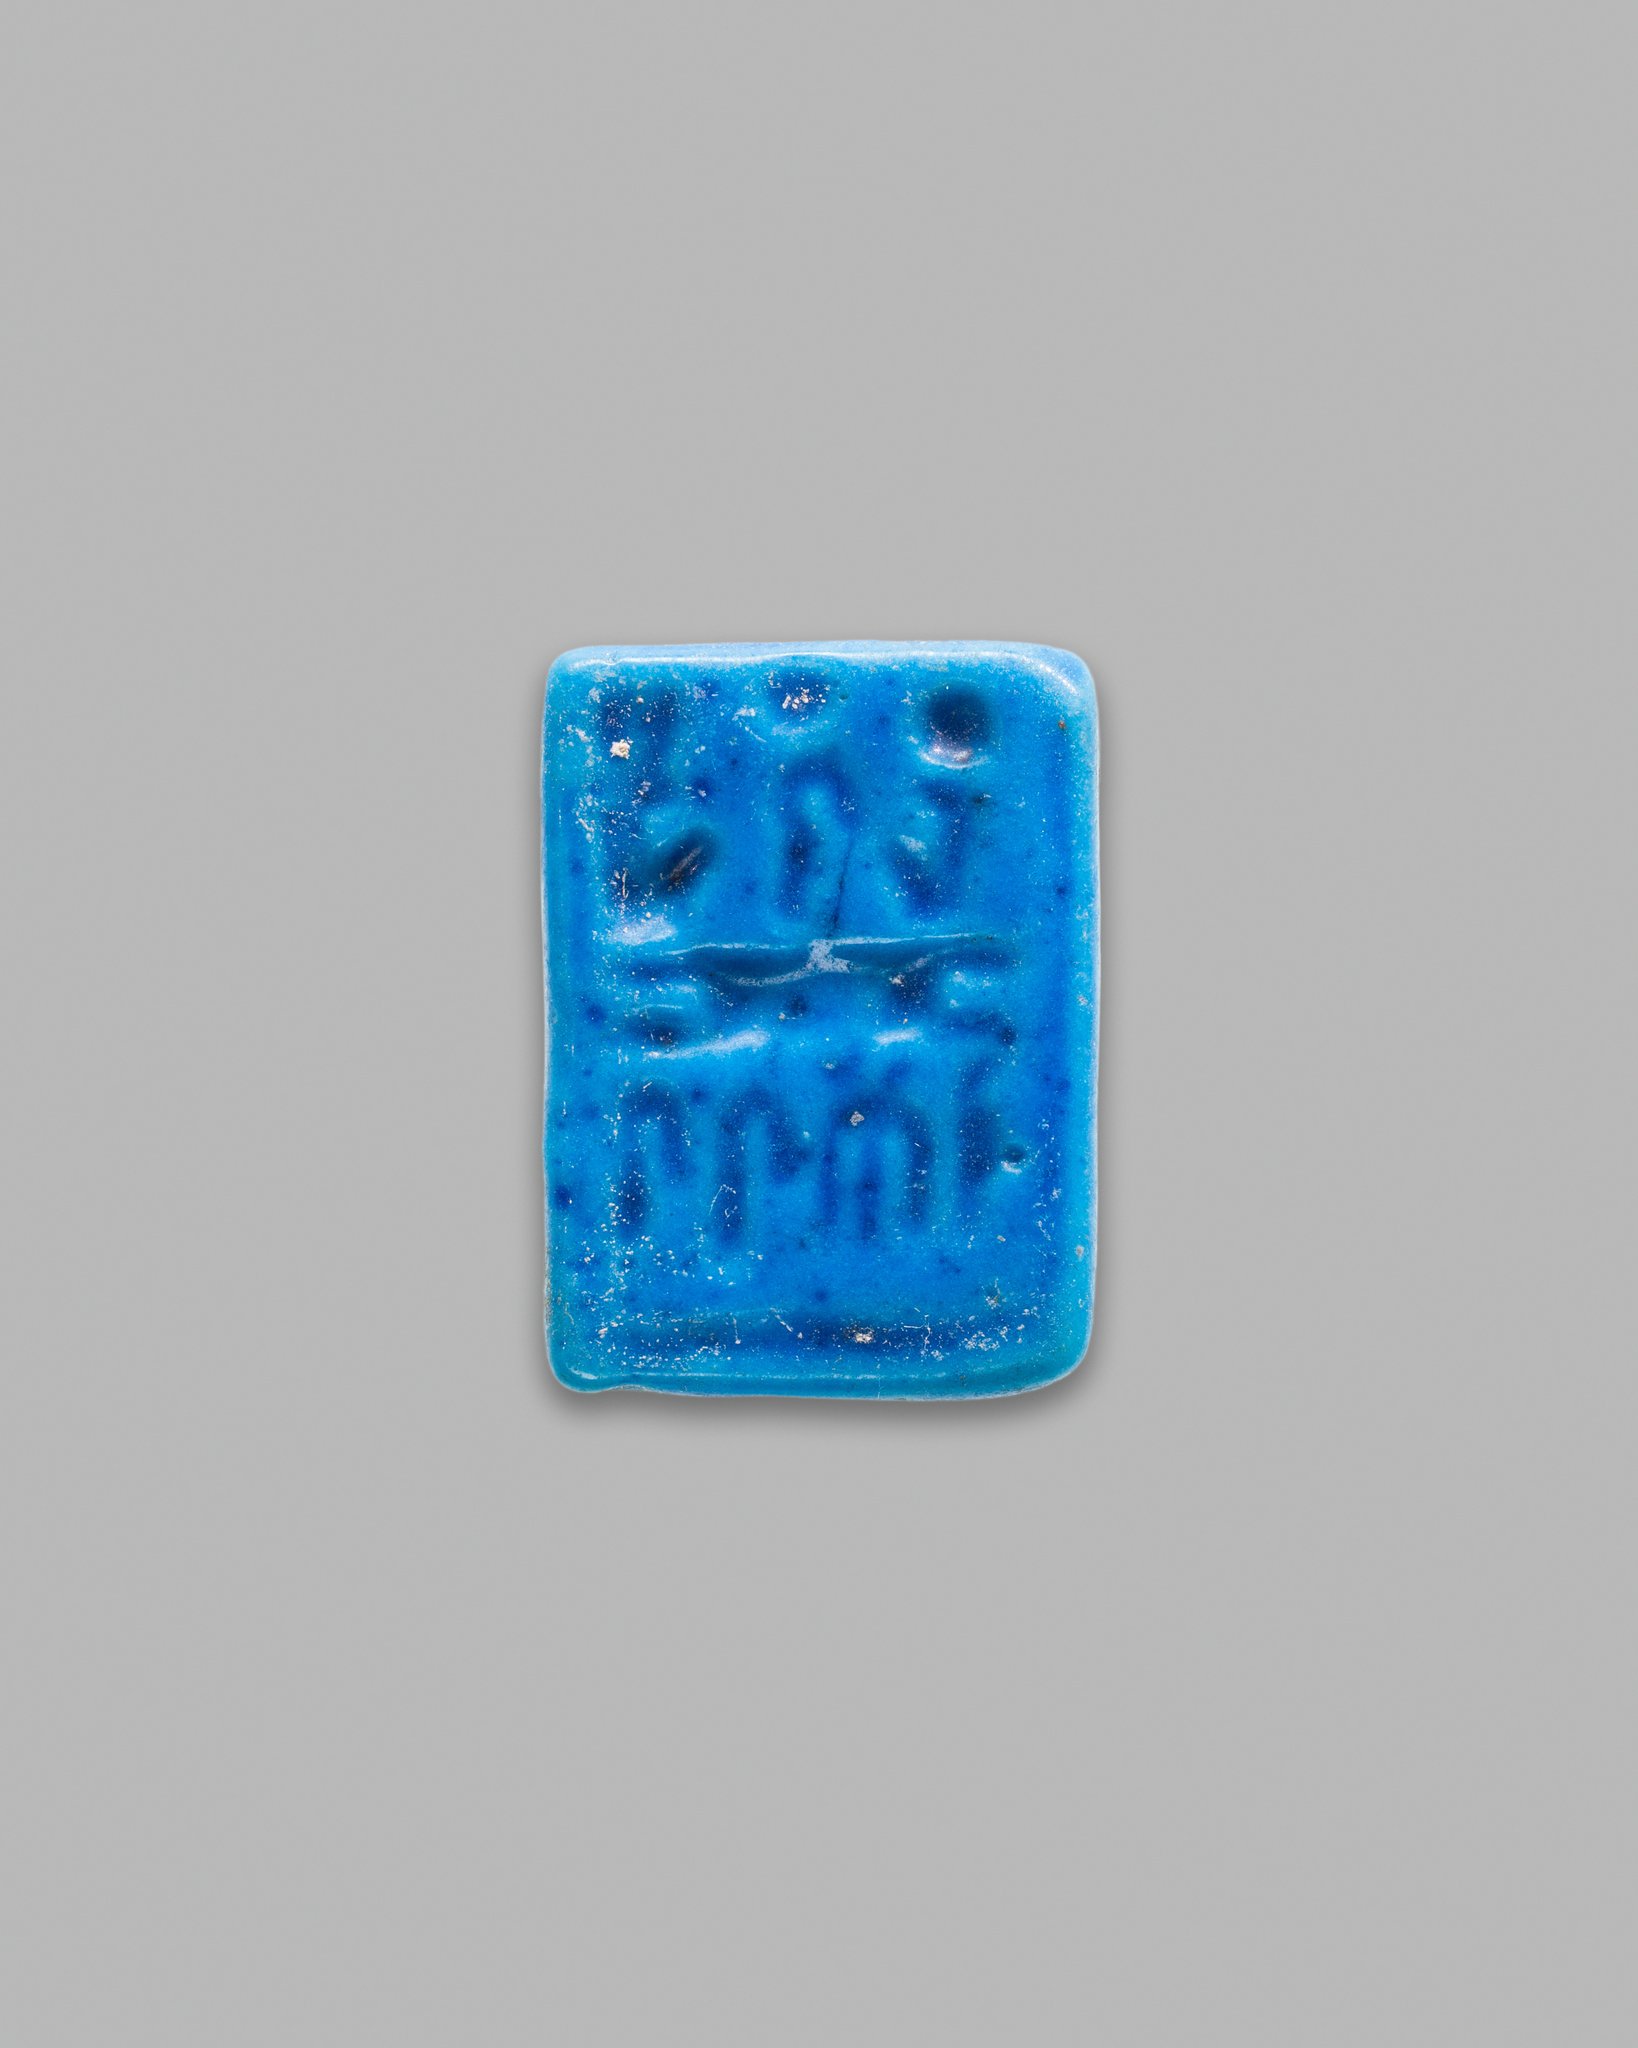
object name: foundation deposit plaque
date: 1153-1147 BCE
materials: faience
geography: egypt